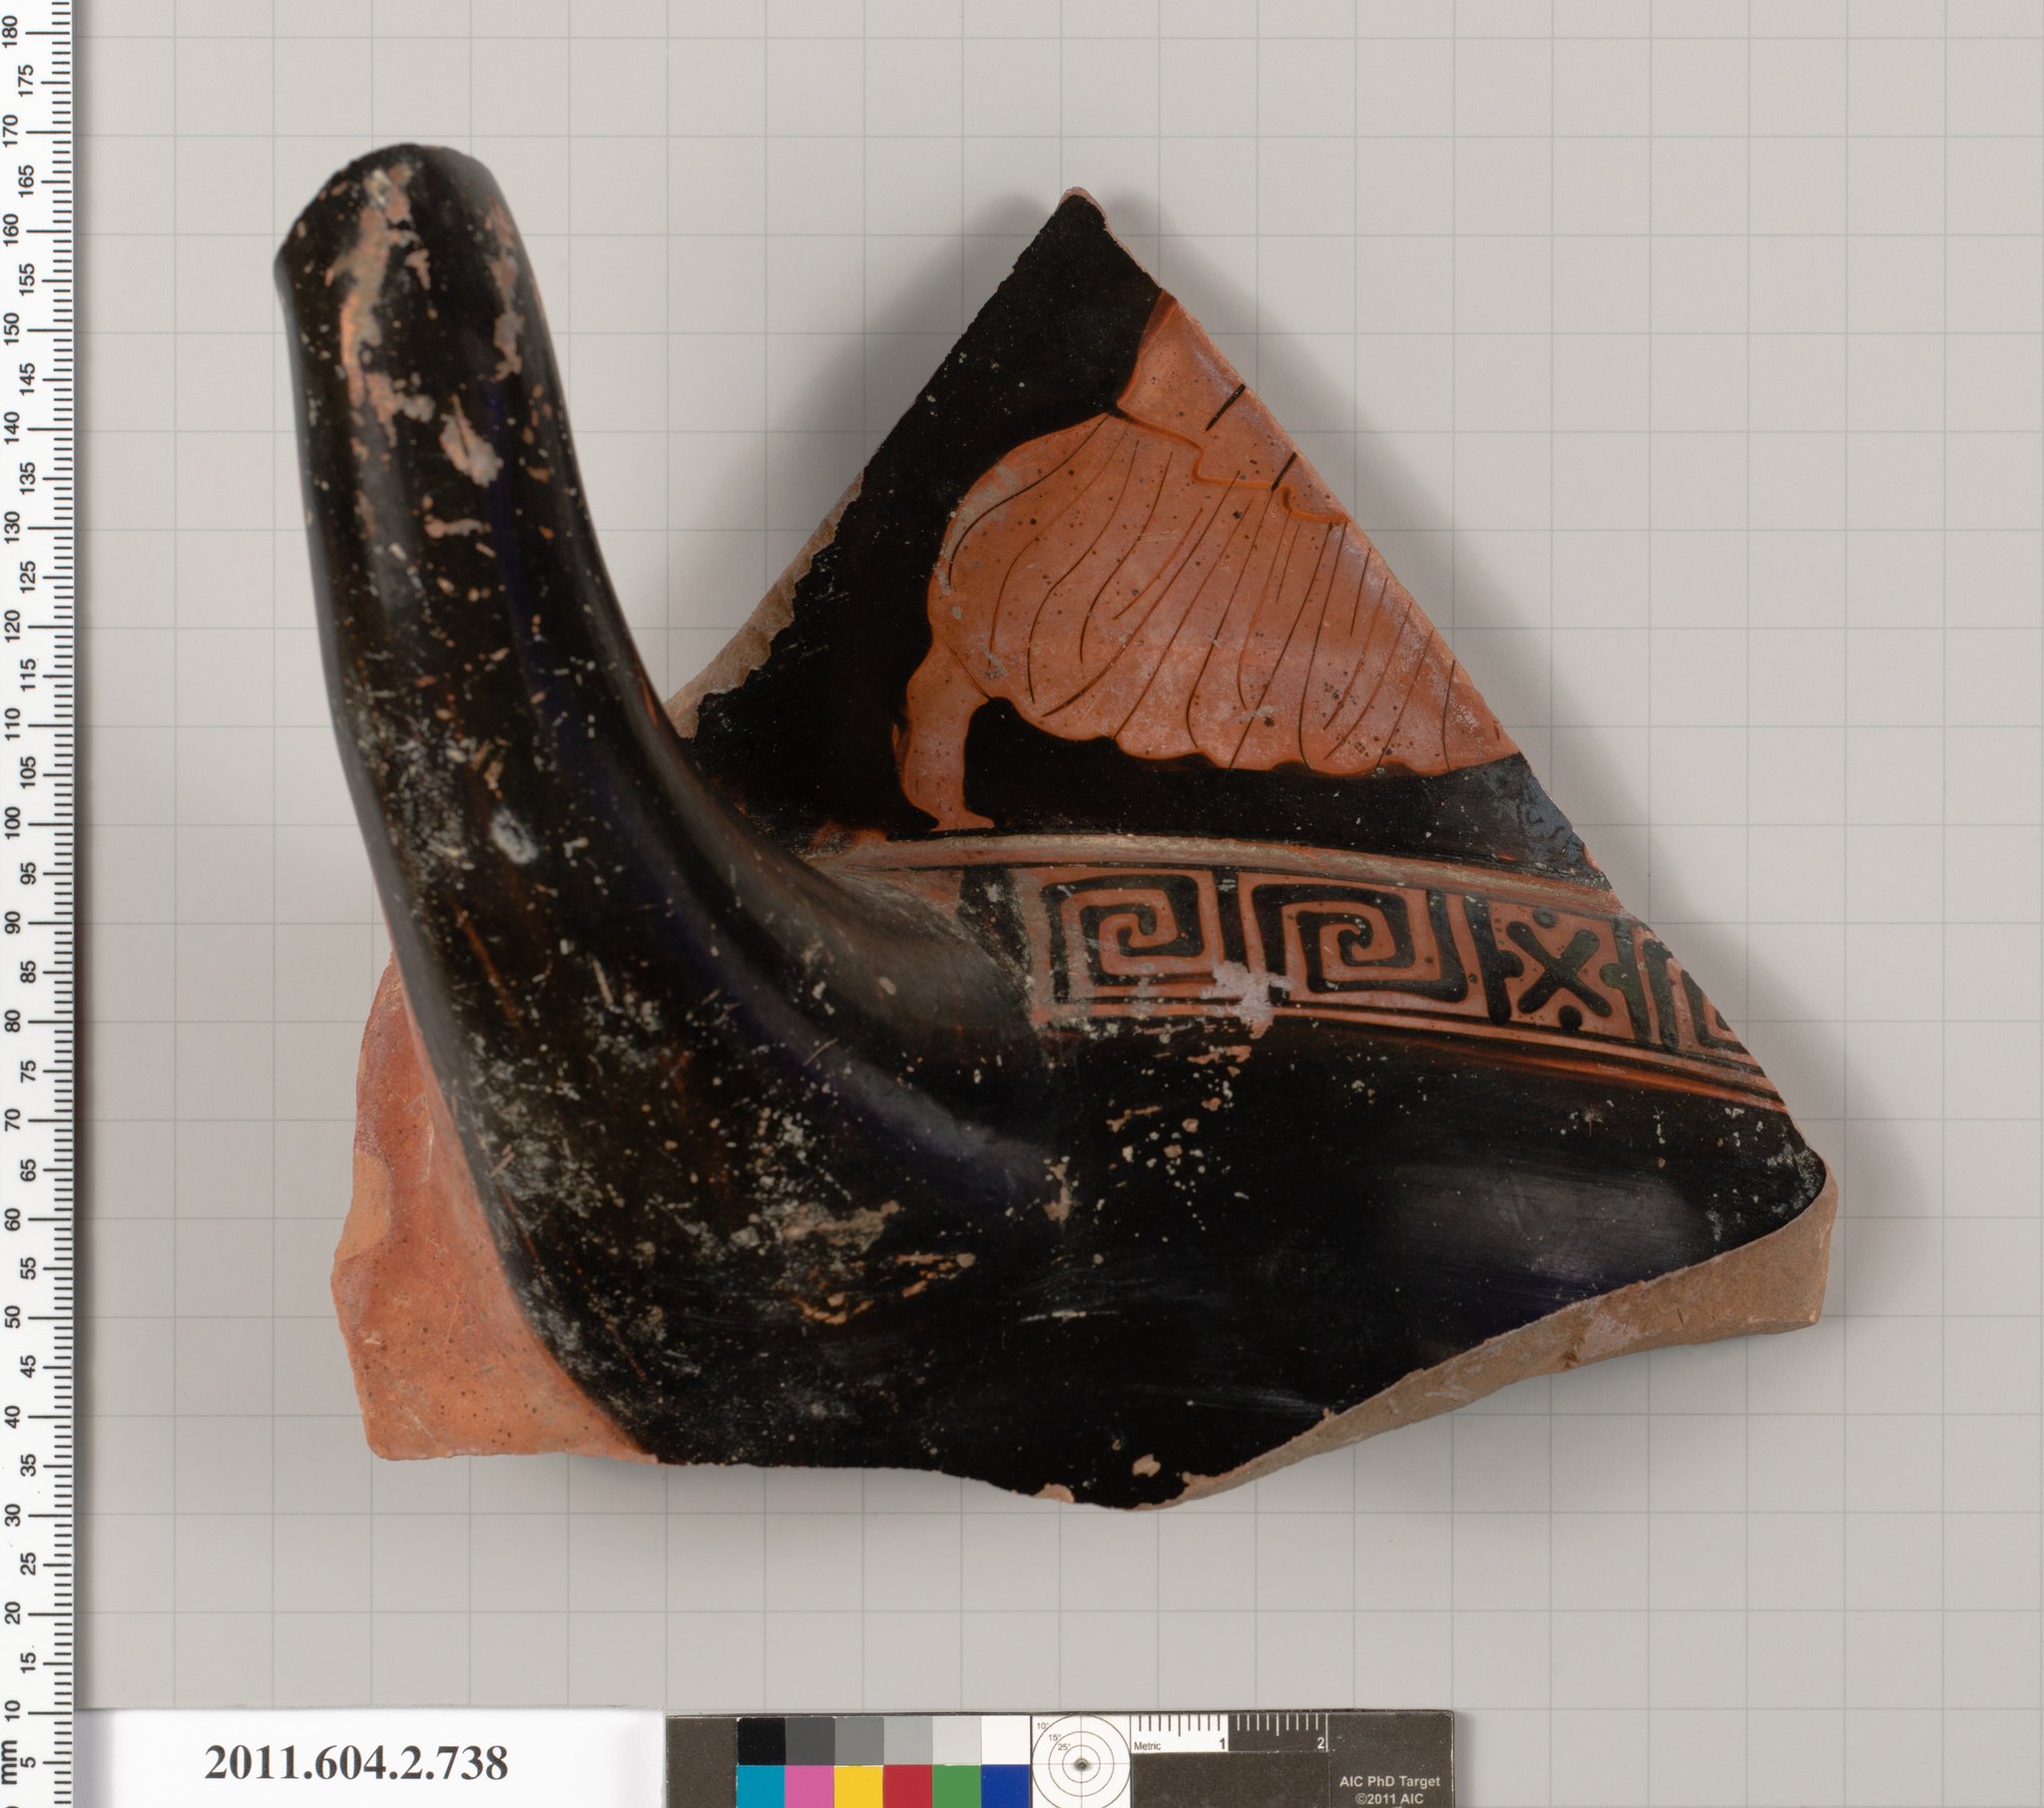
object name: calyx krater fragment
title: Terracotta fragment of a calyx-krater (bowl for mixing wine and water)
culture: greek, attic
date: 467-435 BCE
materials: terracotta